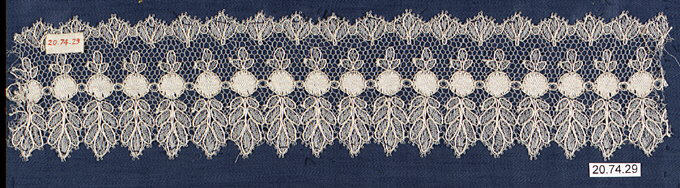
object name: fragment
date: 1801-1900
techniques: lace